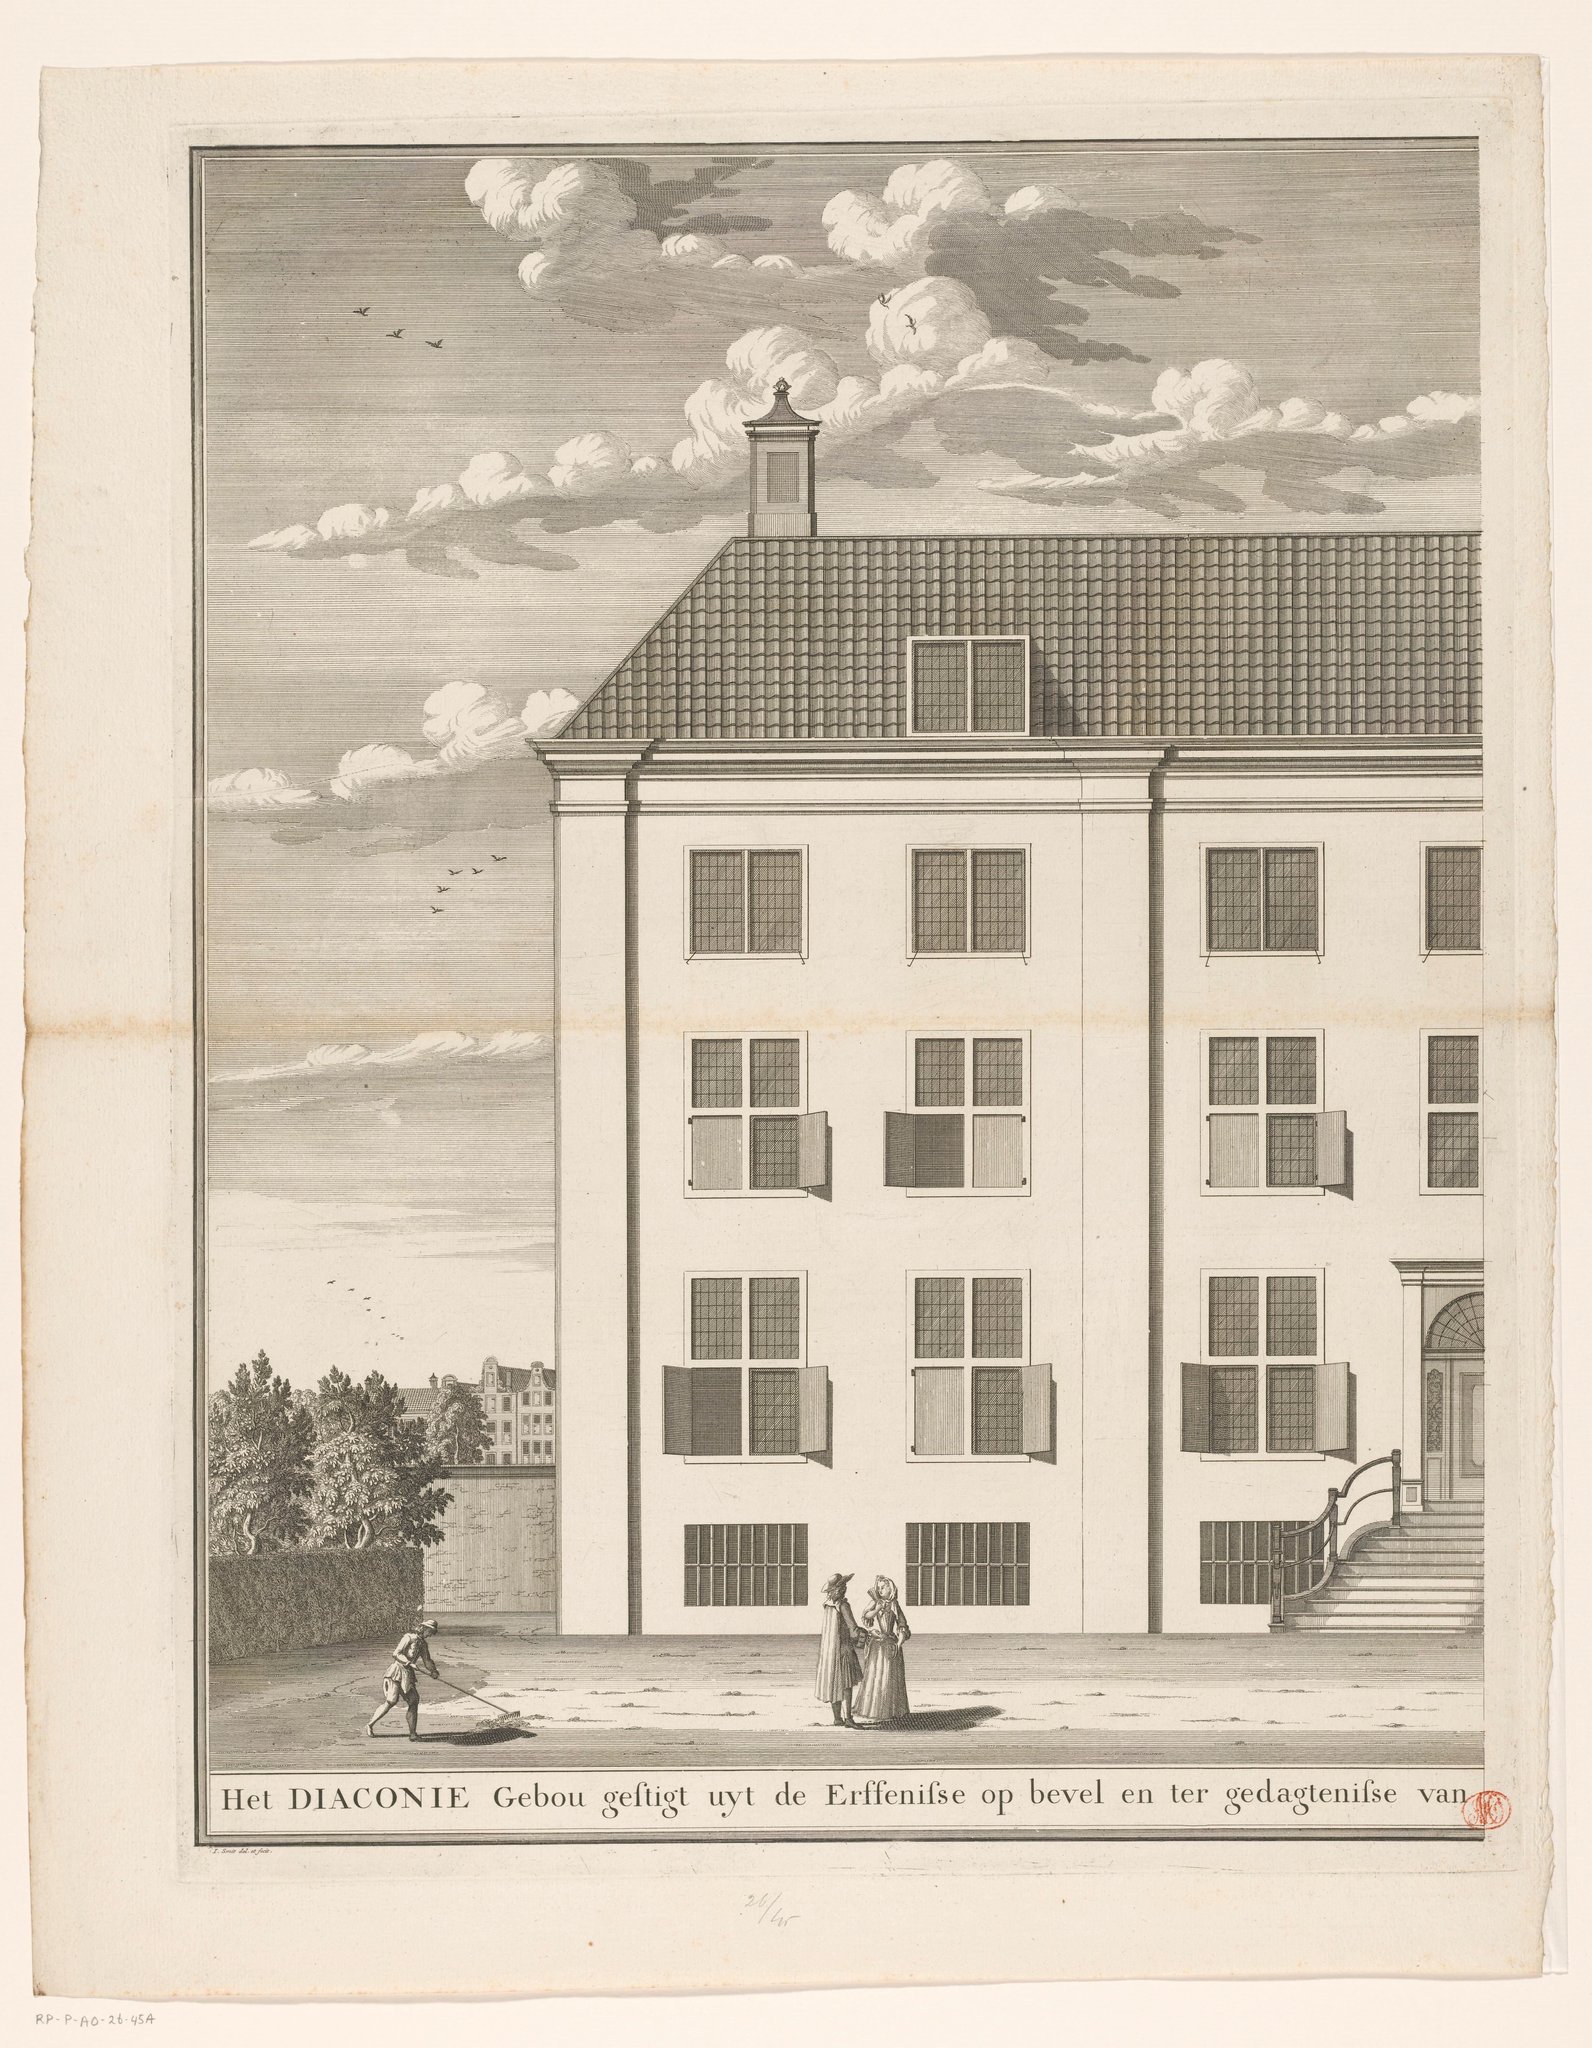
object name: print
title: Gezicht op de achtergevel van het Corvershof te Amsterdam (linkerdeel)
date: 1723-1748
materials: paper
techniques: engraving, etching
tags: alms-house (dutch: 'hofje'), public welfare, old-people's home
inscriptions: collector's mark: Lugt 195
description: Zie ook RP-P-AO-26-45, RP-P-AO-26-46, RP-P-AO-26-47, RP-P-AO-26-48, RP-P-AO-26-49, RP-P-AO-26-50, RP-P-AO-26-51, RP-P-AO-26-52, RP-P-AO-26-53 en RP-P-AO-26-54.